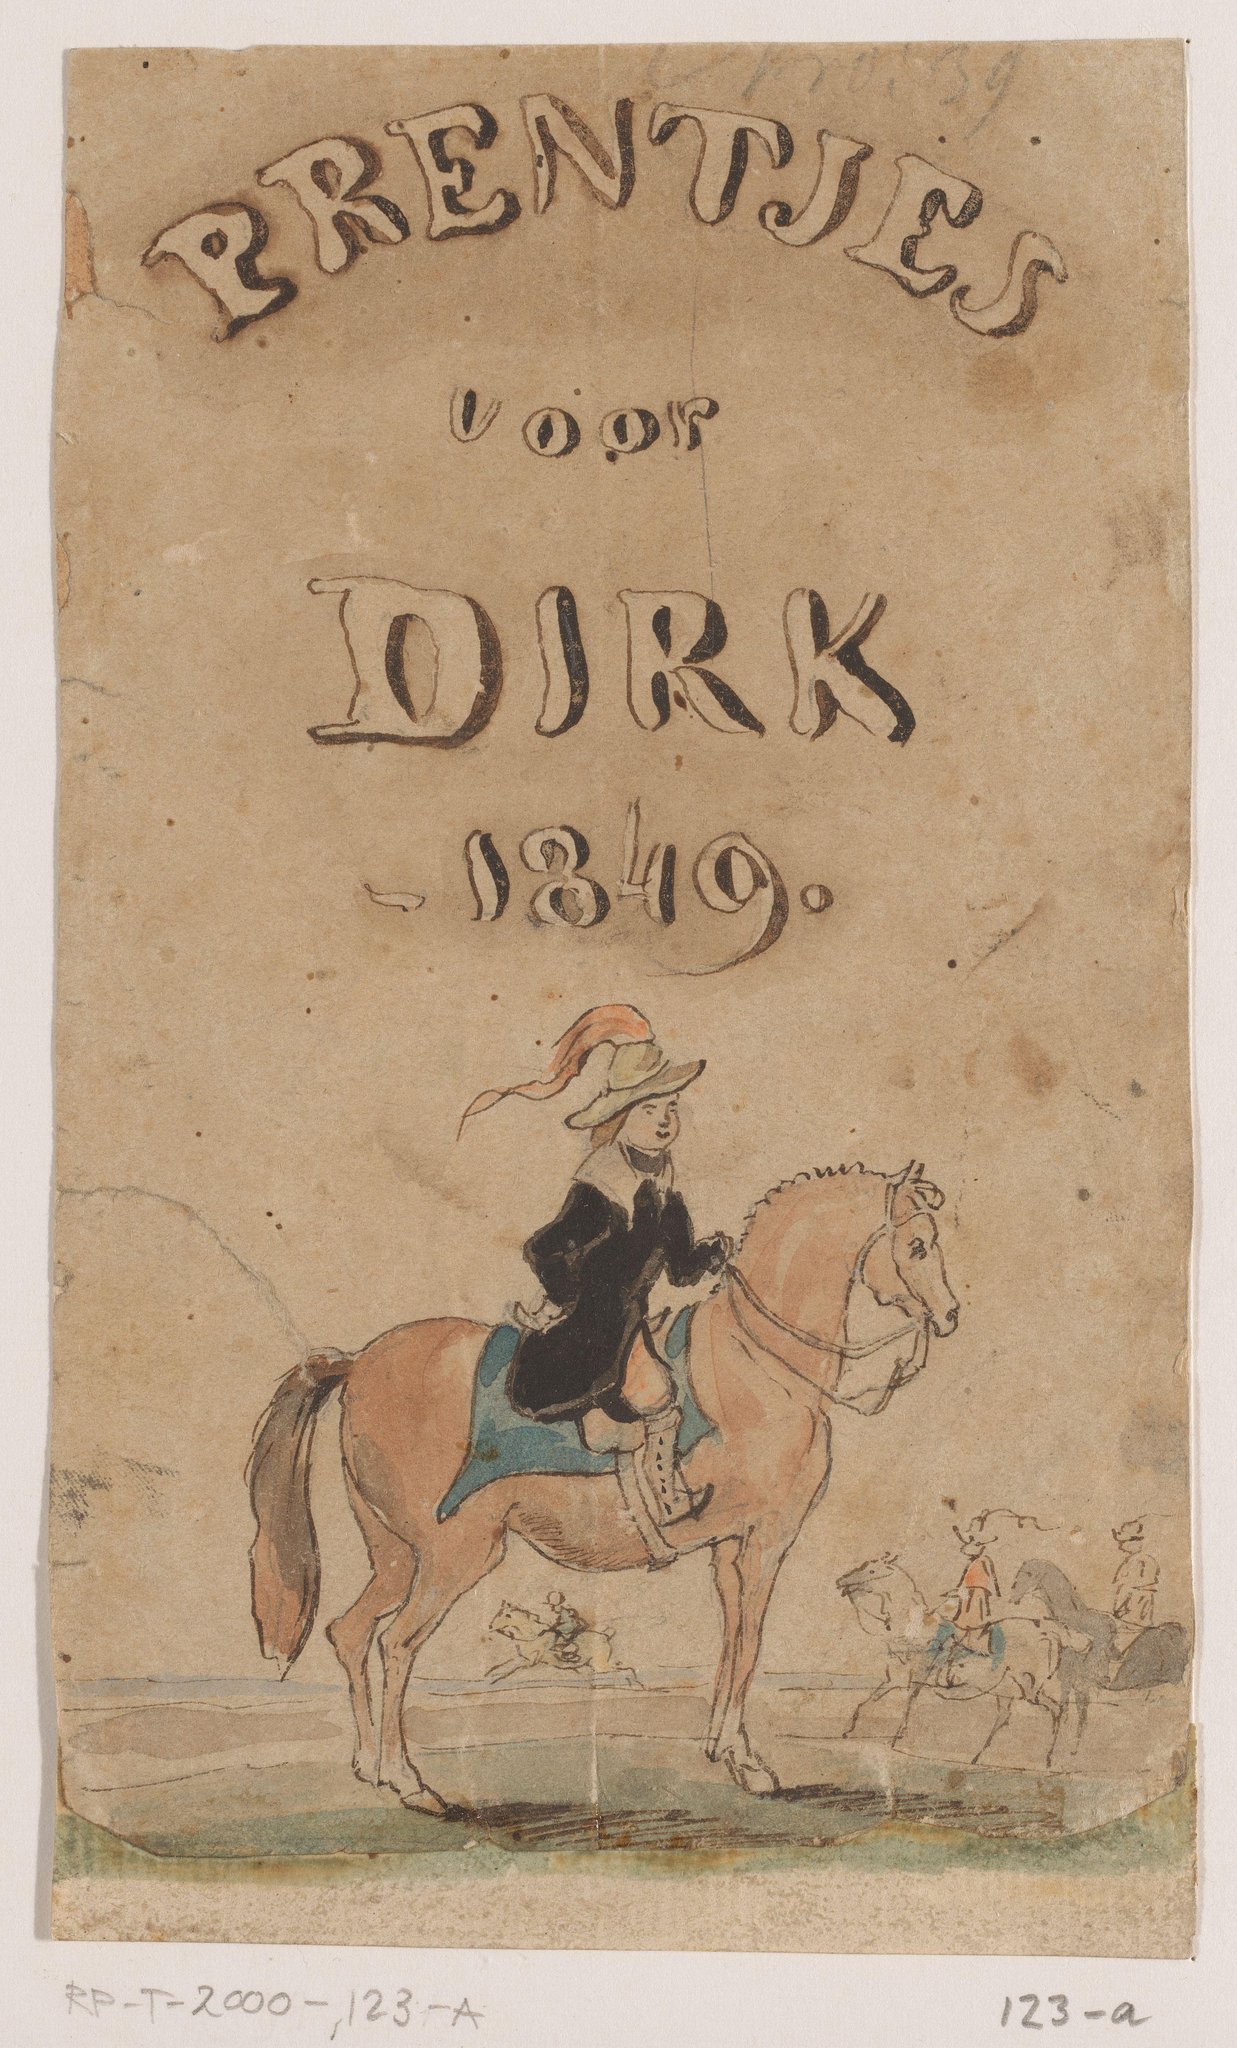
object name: drawing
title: Prentjes voor Dirk 1849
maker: johannes tavenraat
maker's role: draughtsman, painter, print maker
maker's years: 1809-1881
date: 1849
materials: ink, paper, pencil, watercolor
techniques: brush, pen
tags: riding a horse, ass, or mule; rider, horseman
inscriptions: collector's mark: Lugt 2228, inscription: ‘Prentjes voor Dirk - 1849.’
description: Ruiter met hoed met pluim, in een landschap met enkele andere ruiters. Titelblad voor een getekend prentenboekje voor zijn zoon Dirk Tavenraat.